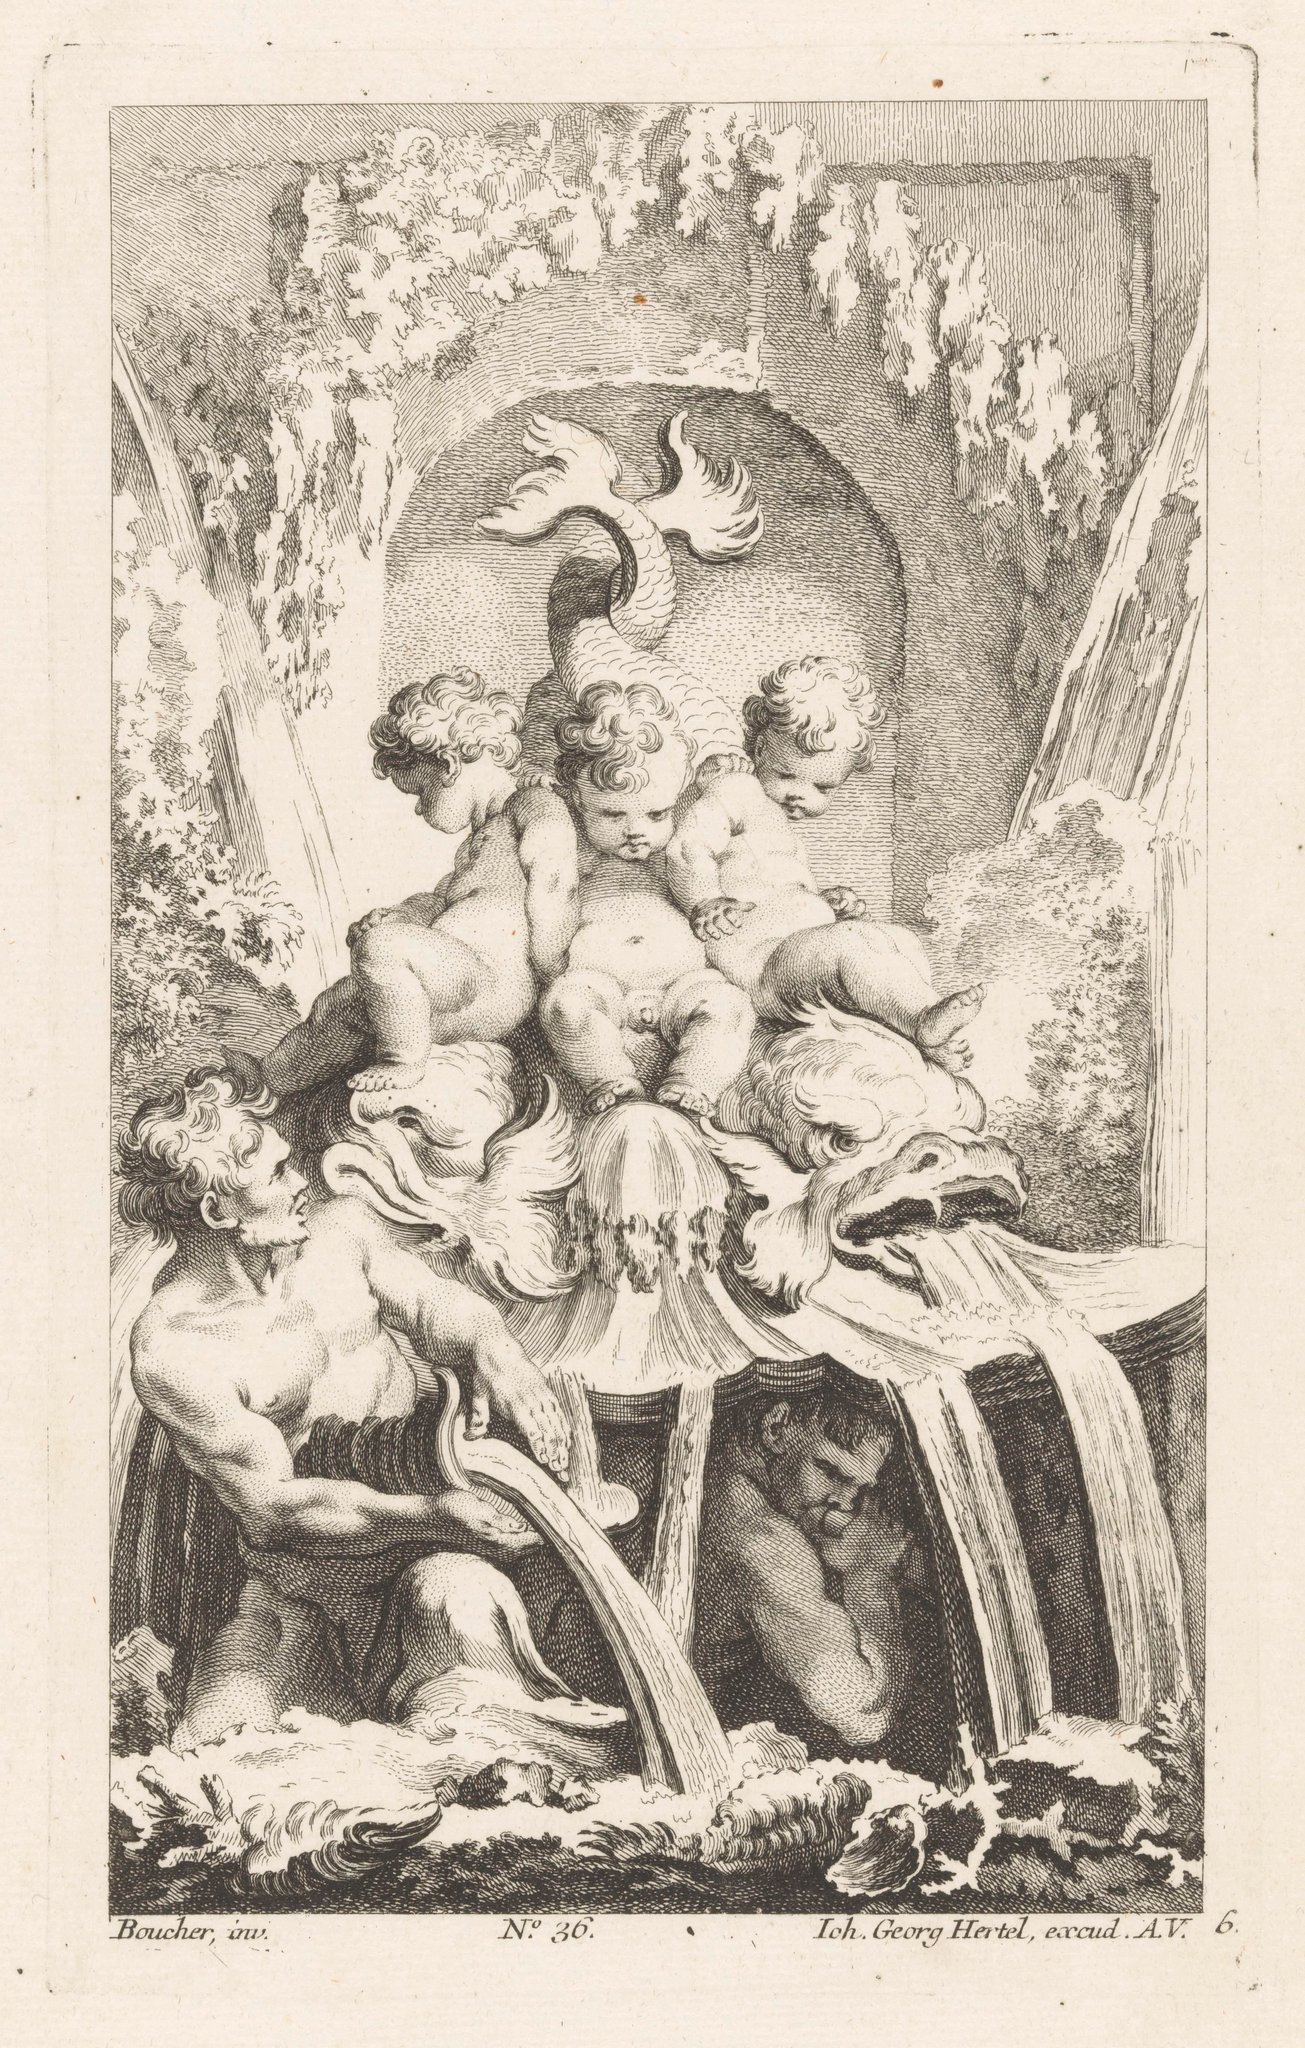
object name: print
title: Diverses Fontaines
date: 1713-1760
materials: paper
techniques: etching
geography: augsburg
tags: sitting figure, dolphin ~ ornament, ornamental fountain, cupids: 'amores', 'amoretti', 'putti'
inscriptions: collector's mark: Lugt 2760, collector's mark: Lugt 2228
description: Drie putti zitten op een fontein met twee dolfijnen. Links zit een man met een schelp waar water uit stroomt, onder de fontein zit een tweede man. Uitgeversnummer 36.